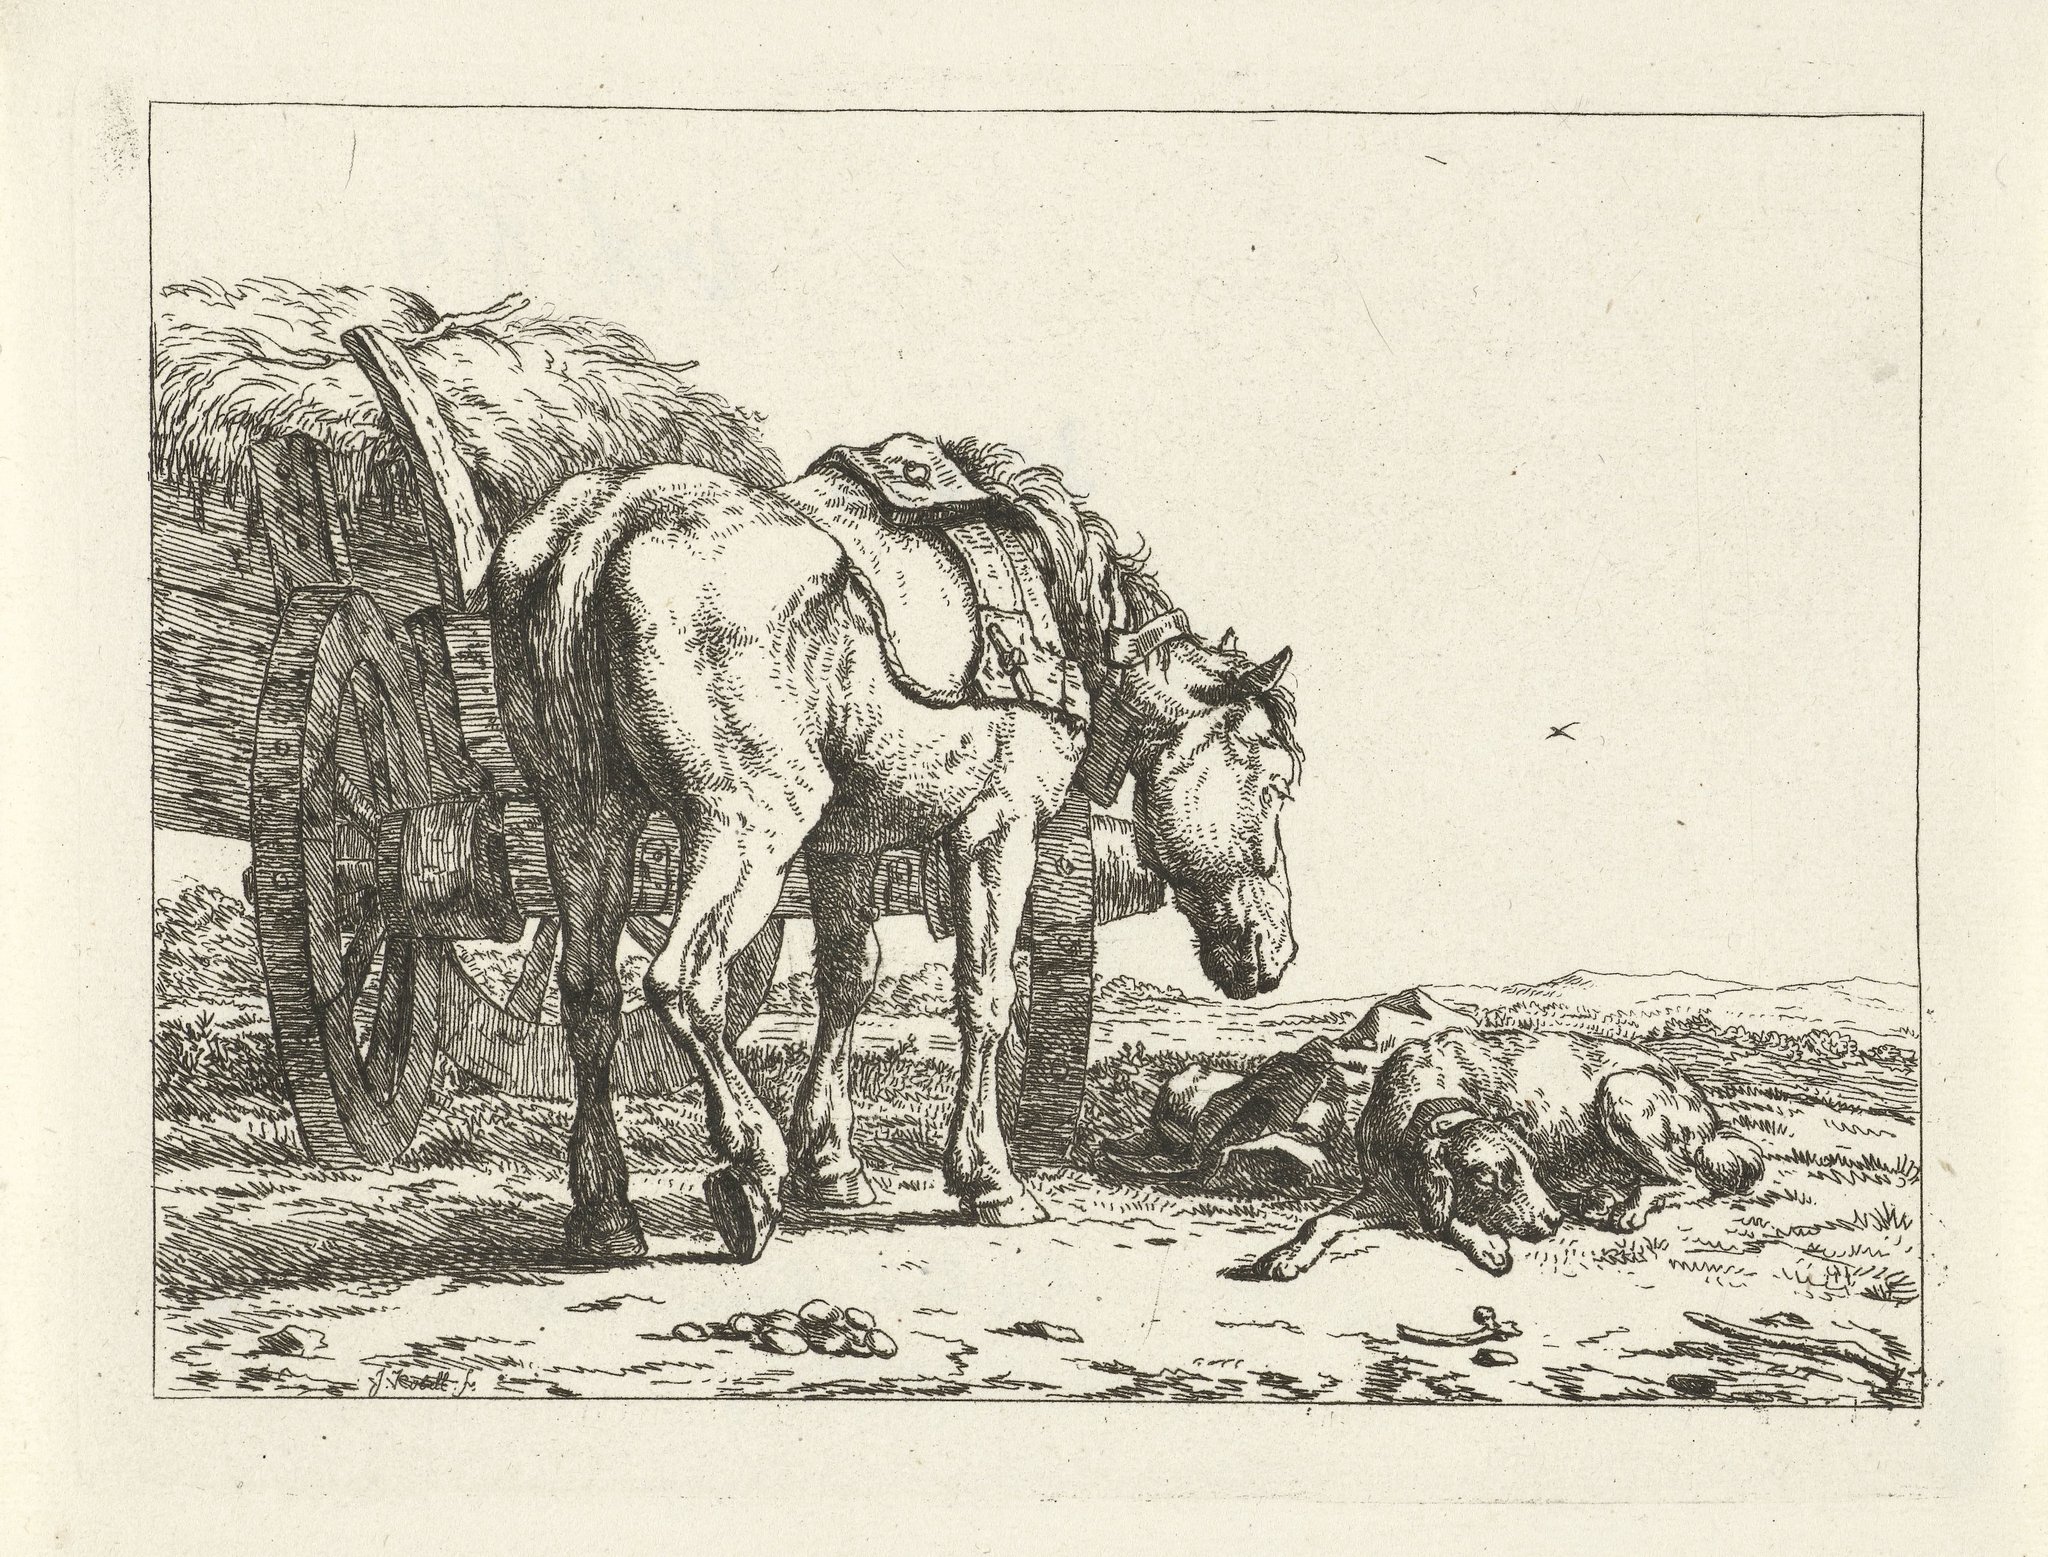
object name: print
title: Paard en hond bij een hooiwagen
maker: jan kobell (ii)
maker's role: draughtsman, painter, print maker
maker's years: 1778-1814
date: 1788-1814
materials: paper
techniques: etching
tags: landscapes, horse, hay-wagon, dog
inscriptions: collector's mark: Lugt 2228, collector's mark: Lugt 2760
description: In een glooiend landschap staat een hooiwagen met daarnaast een paard, van achter gezien. Naast het paard een slapende hond.